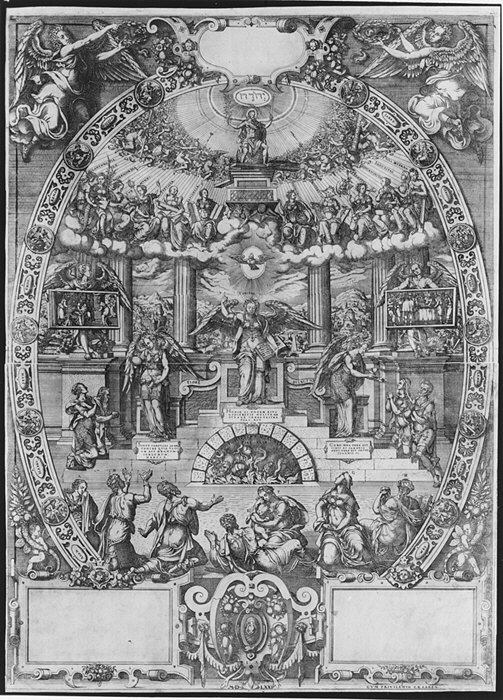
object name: print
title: Triumph of Christian Faith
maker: jost amman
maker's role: artist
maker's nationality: swiss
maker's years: 1539-1591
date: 1501-1600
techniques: etching, printing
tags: angels